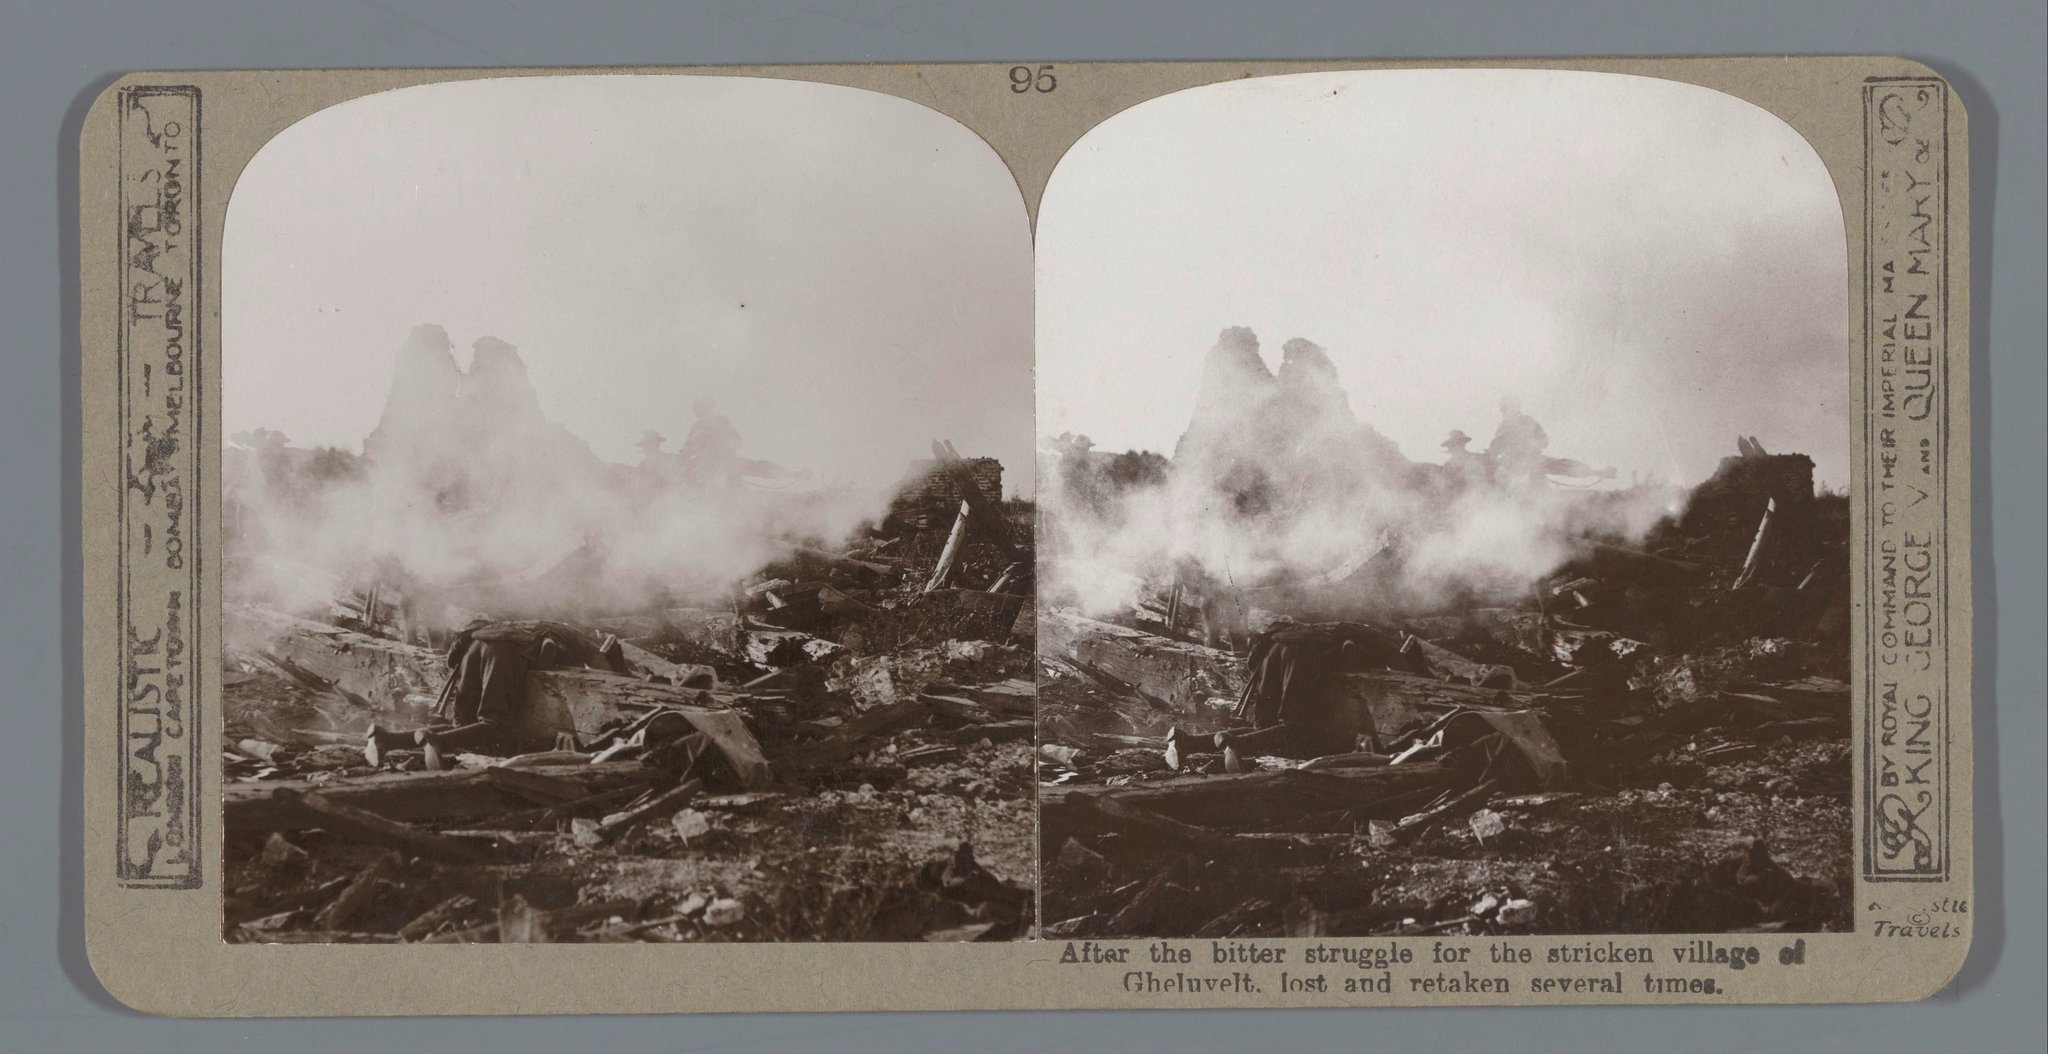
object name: stereograph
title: After the bitter struggle for the stricken village of Gheluvelt, lost and retaken several times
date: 1909-1918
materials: cardboard, photographic support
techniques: gelatin silver print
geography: geluveld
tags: destruction of conquered city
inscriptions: number: ‘95’, inscription: ‘By Royal command to their Imperial majesties King George V and Queen Mary’